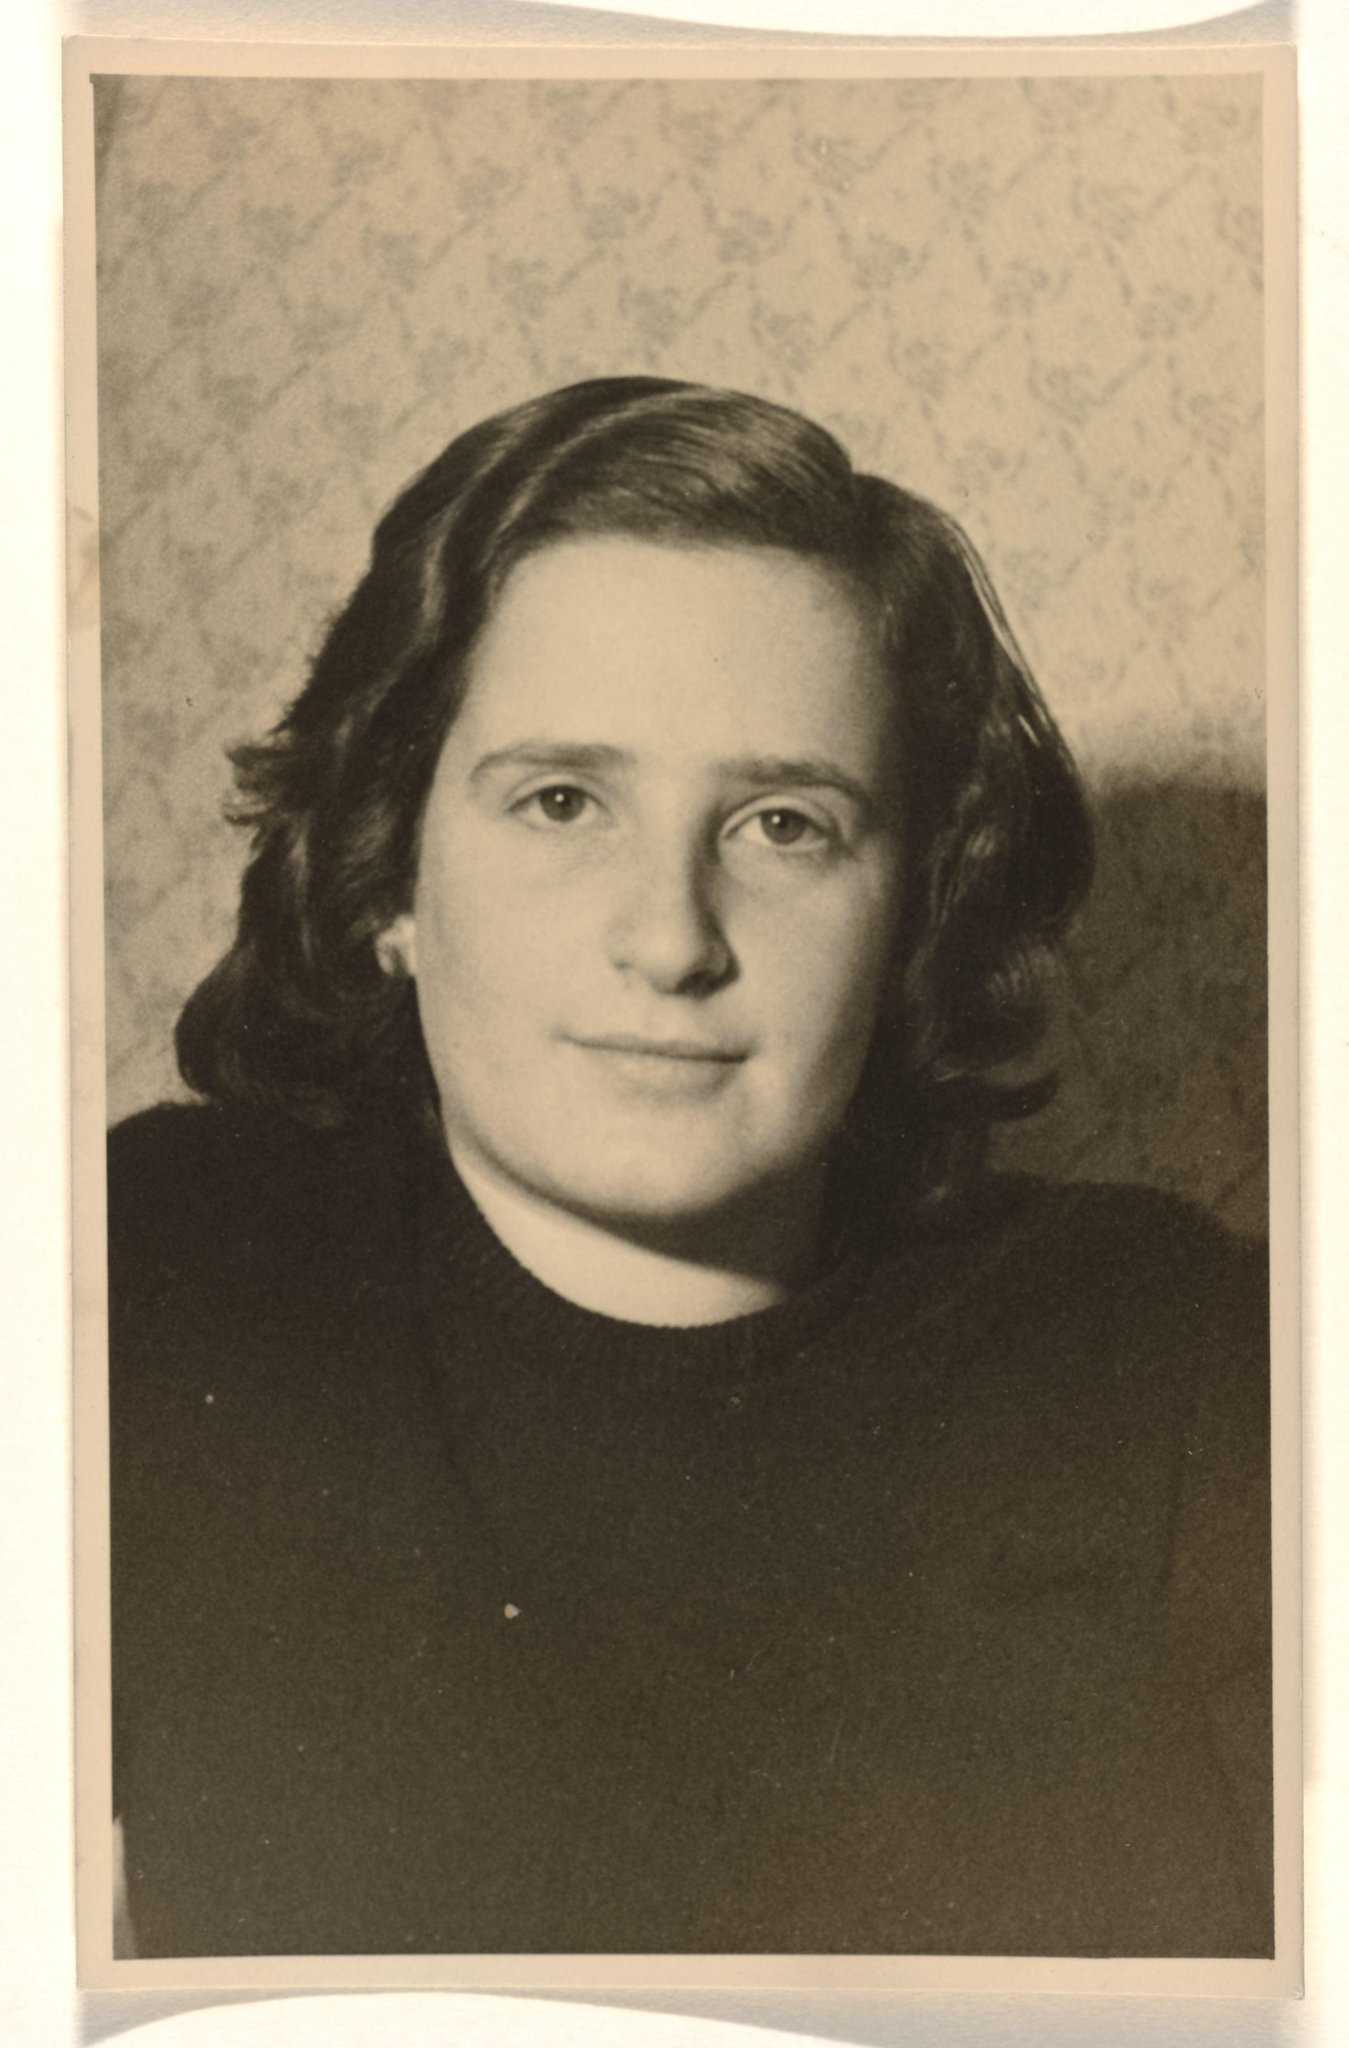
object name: photograph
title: Portret van Isabel Wachenheimer, bedoeld als eerste tekenen van leven aan Leo Blumensohn, 25 september 1945 in Davos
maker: Anonymous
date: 1945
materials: photographic support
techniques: gelatin silver print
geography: davos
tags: leiden, isabel wachenheimer-elon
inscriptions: inscription: ‘(onduidelijke aanhef) Du hast mich über- haupt nicht lieb"!!!!! Wann wirst Du schon endlich ein bisschen ordentlich?? Sei mir nicht böse, ich meine alles nur gut. Vergiss nie Deine Mirjam’